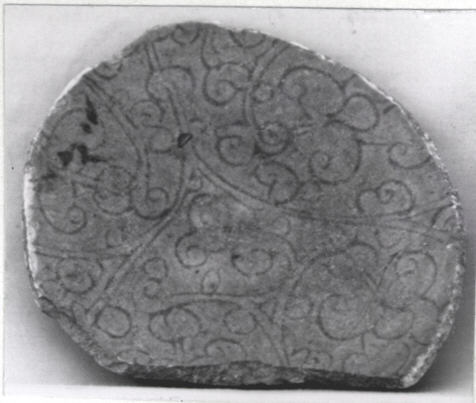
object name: ceramic fragment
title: Fragment of a Dish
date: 1201-1400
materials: earthenware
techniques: glazing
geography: egypt